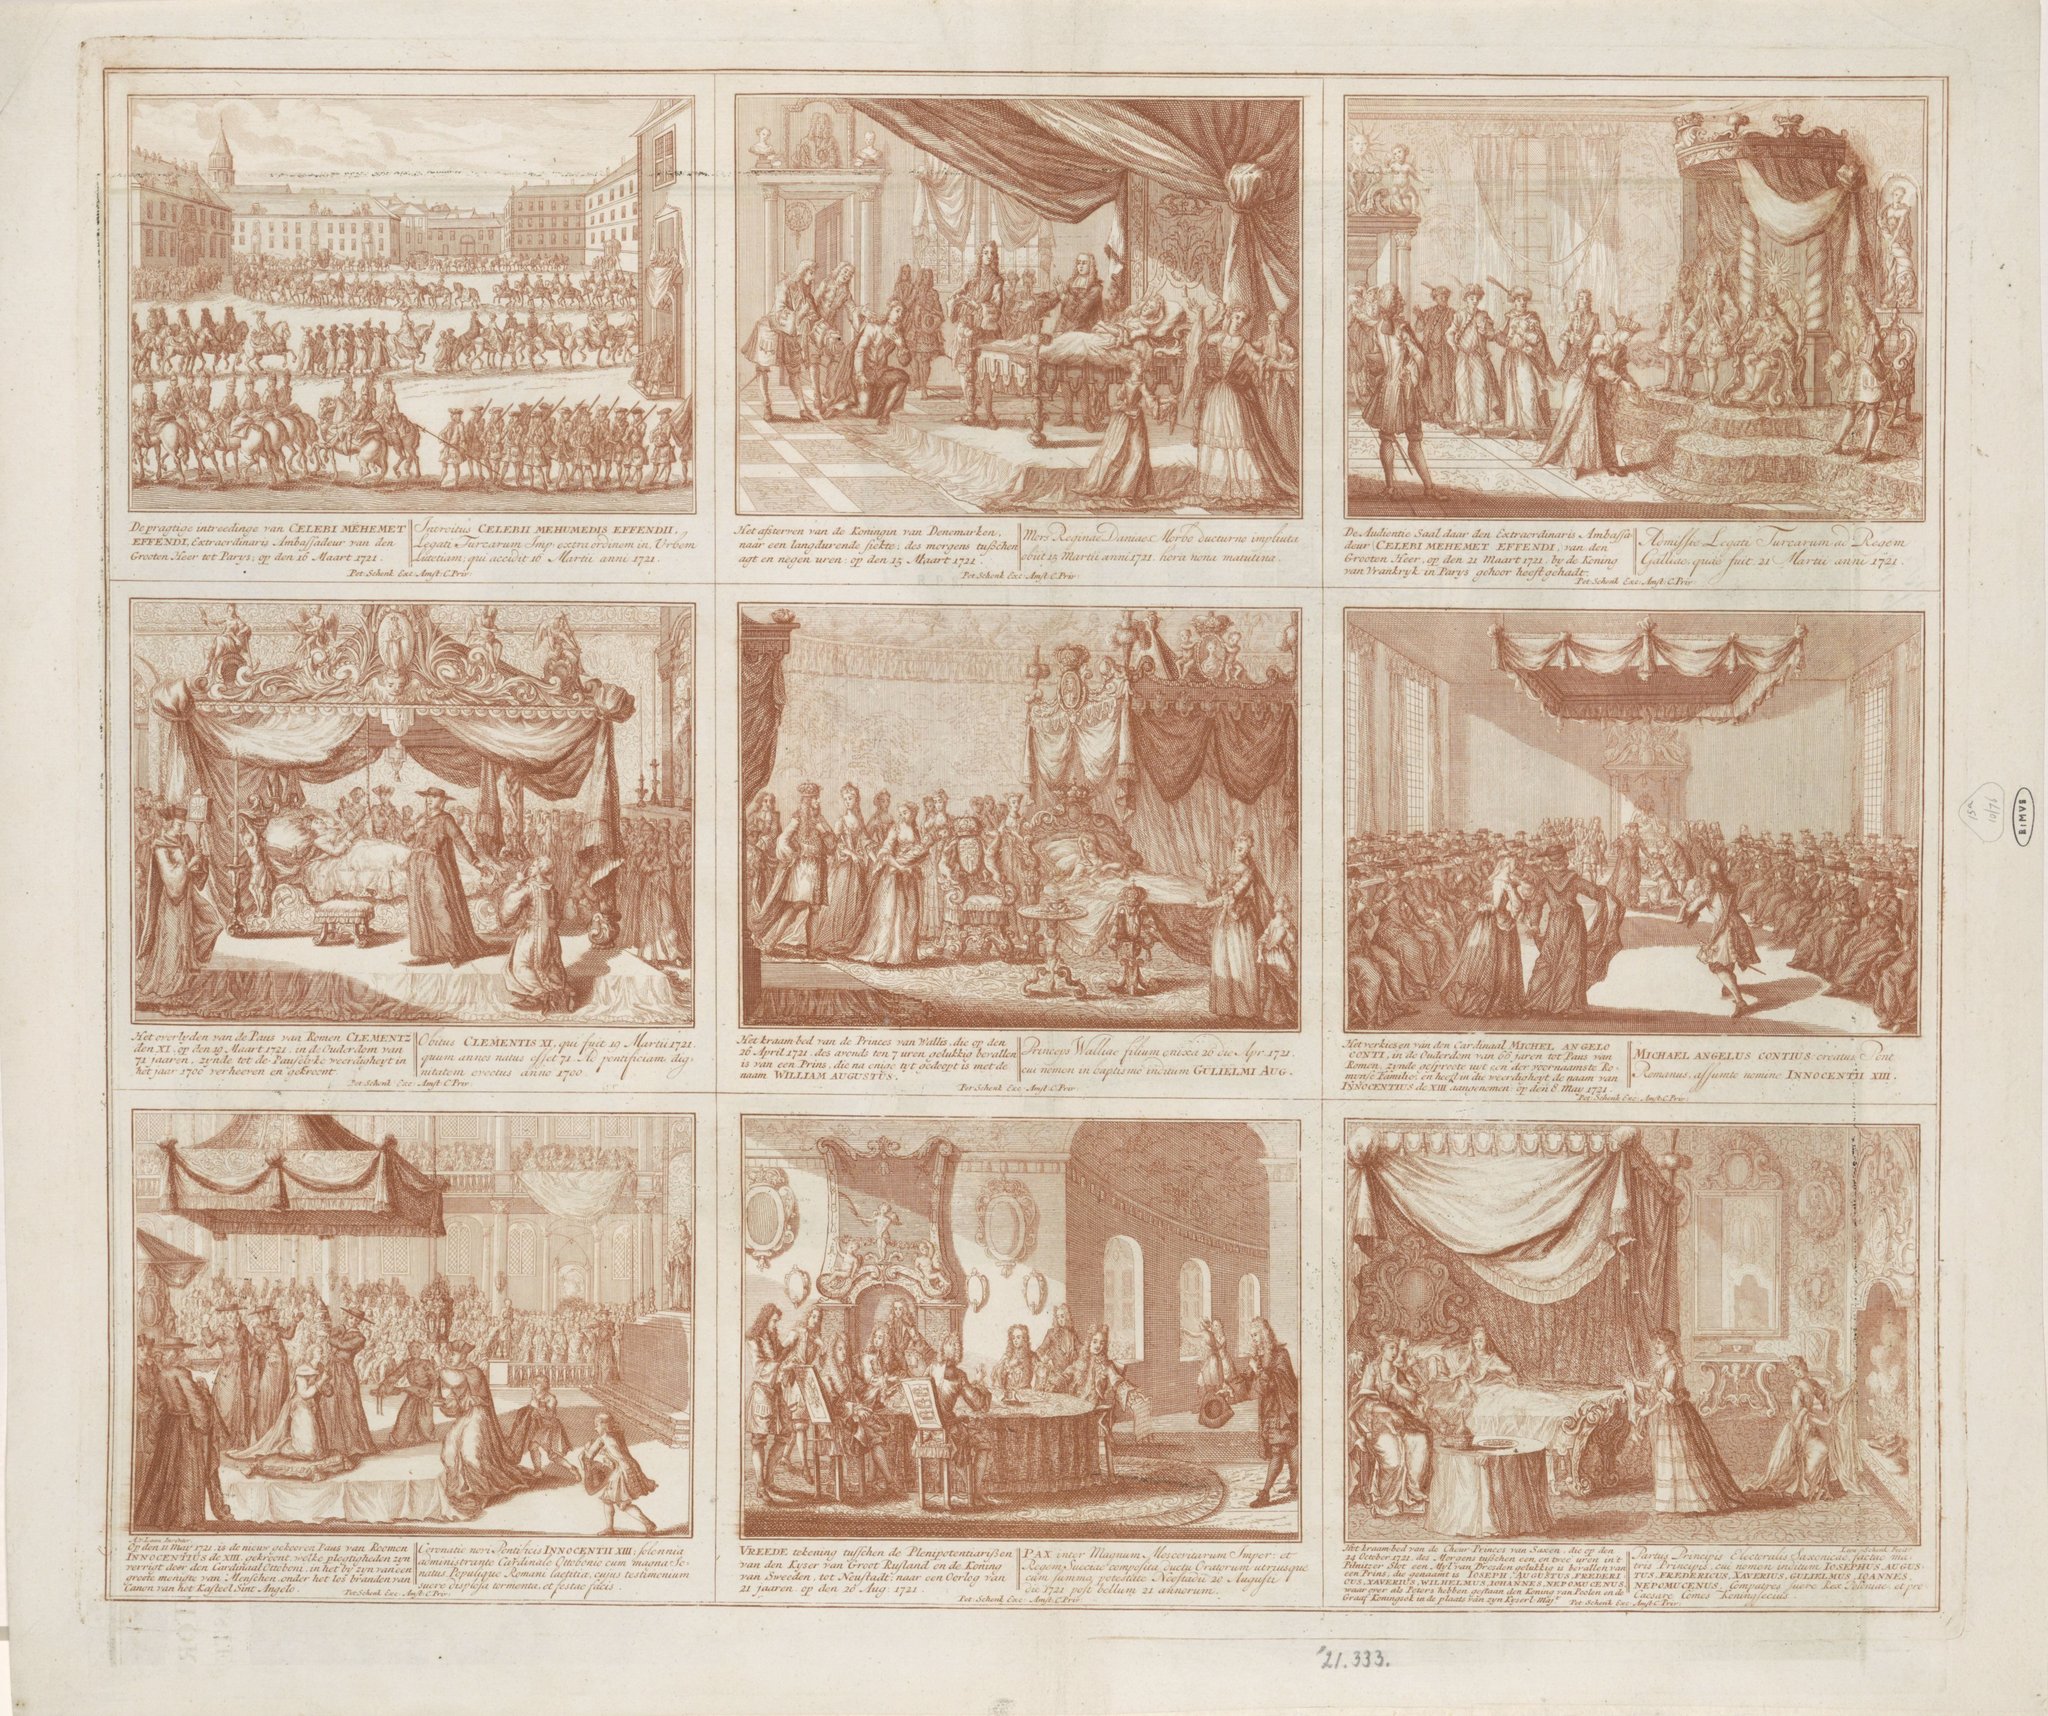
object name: print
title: Schouwburg van den oorlog (blad XXII), 1721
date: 1721-1722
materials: paper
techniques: etching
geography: amsterdam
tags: rome, clergyman, clemens xi, lying-in room, bedroom, historical events and situations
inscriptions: collector's mark: Lugt 2228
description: Blad met negen voorstellingen van gebeurtenissen uit het jaar 1721. Rechtsonder de bevalling van de keurvorstin van Saksen te Pillnitz, 24 oktober 1721.